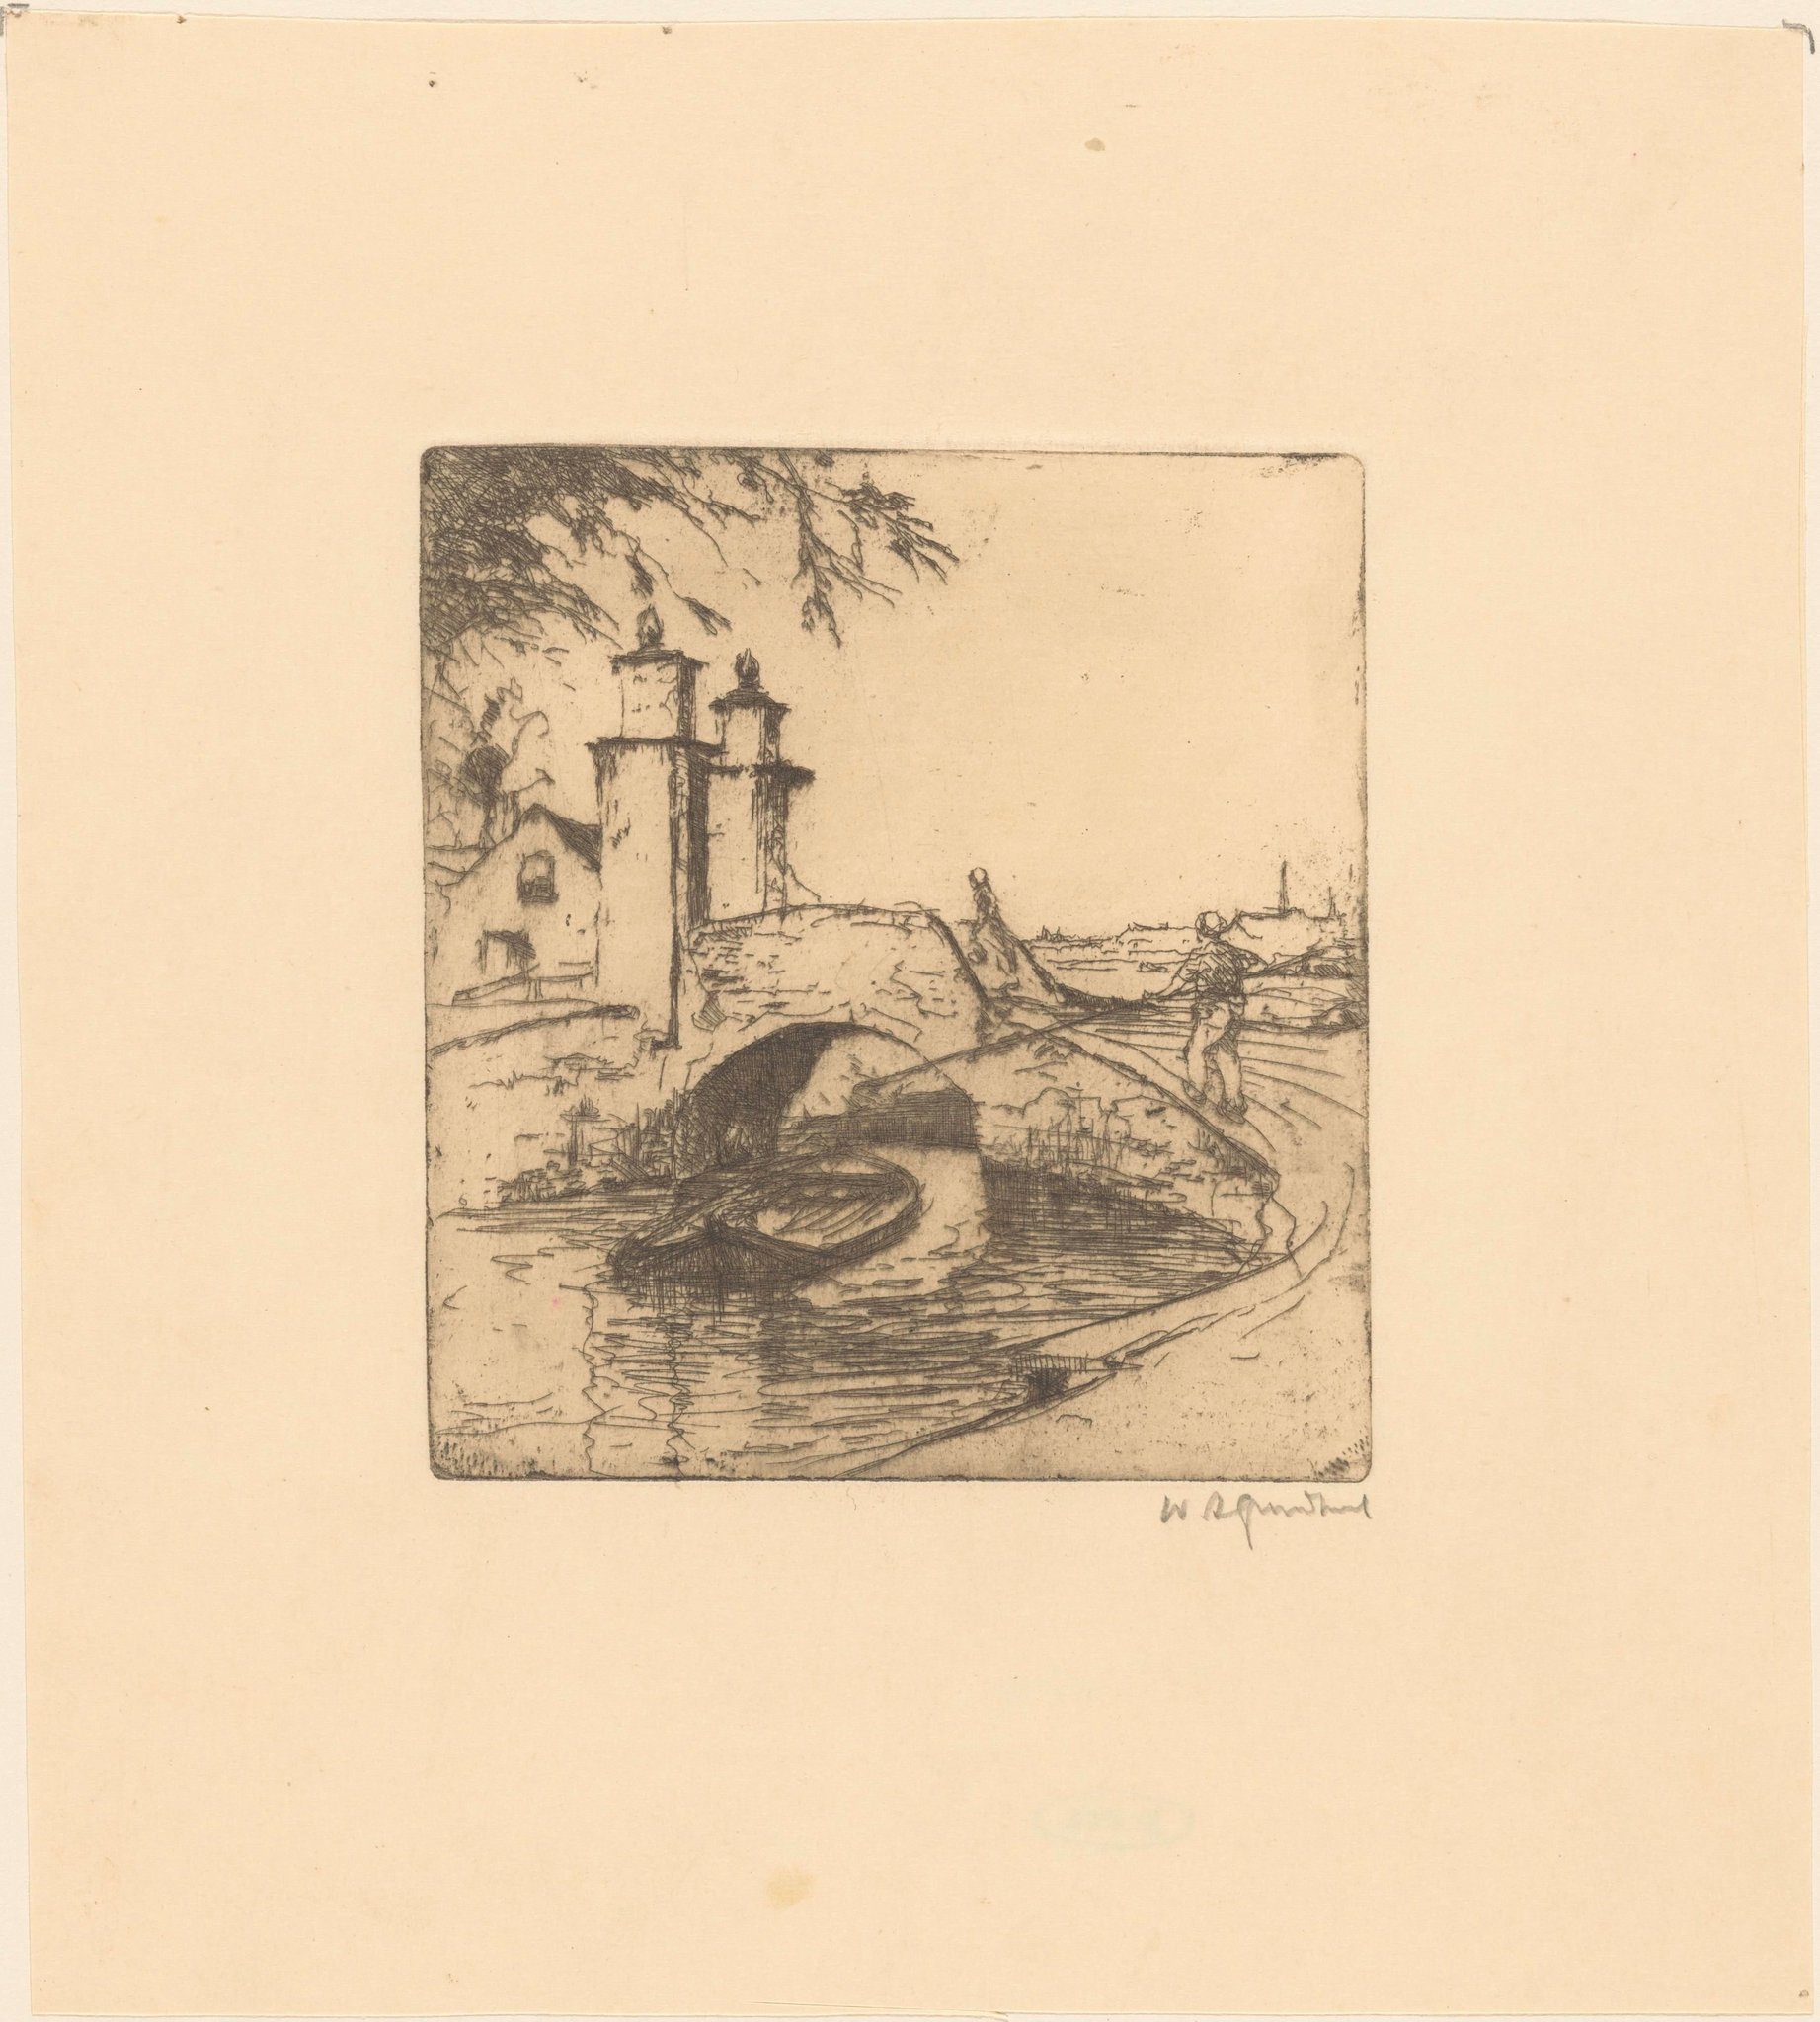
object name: print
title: Brug in Loosduinen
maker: willem adrianus grondhout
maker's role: draughtsman, painter, print maker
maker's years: 1878-1934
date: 1888-1934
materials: paper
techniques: etching, intaglio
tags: bridge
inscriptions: collector's mark: Lugt 2228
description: Een brug aan de Loosduinseweg, ter hoogte van huis Rustenburg in het voormalige dorp Loosduinen, sinds 1923 onderdeel van de stad Den Haag.